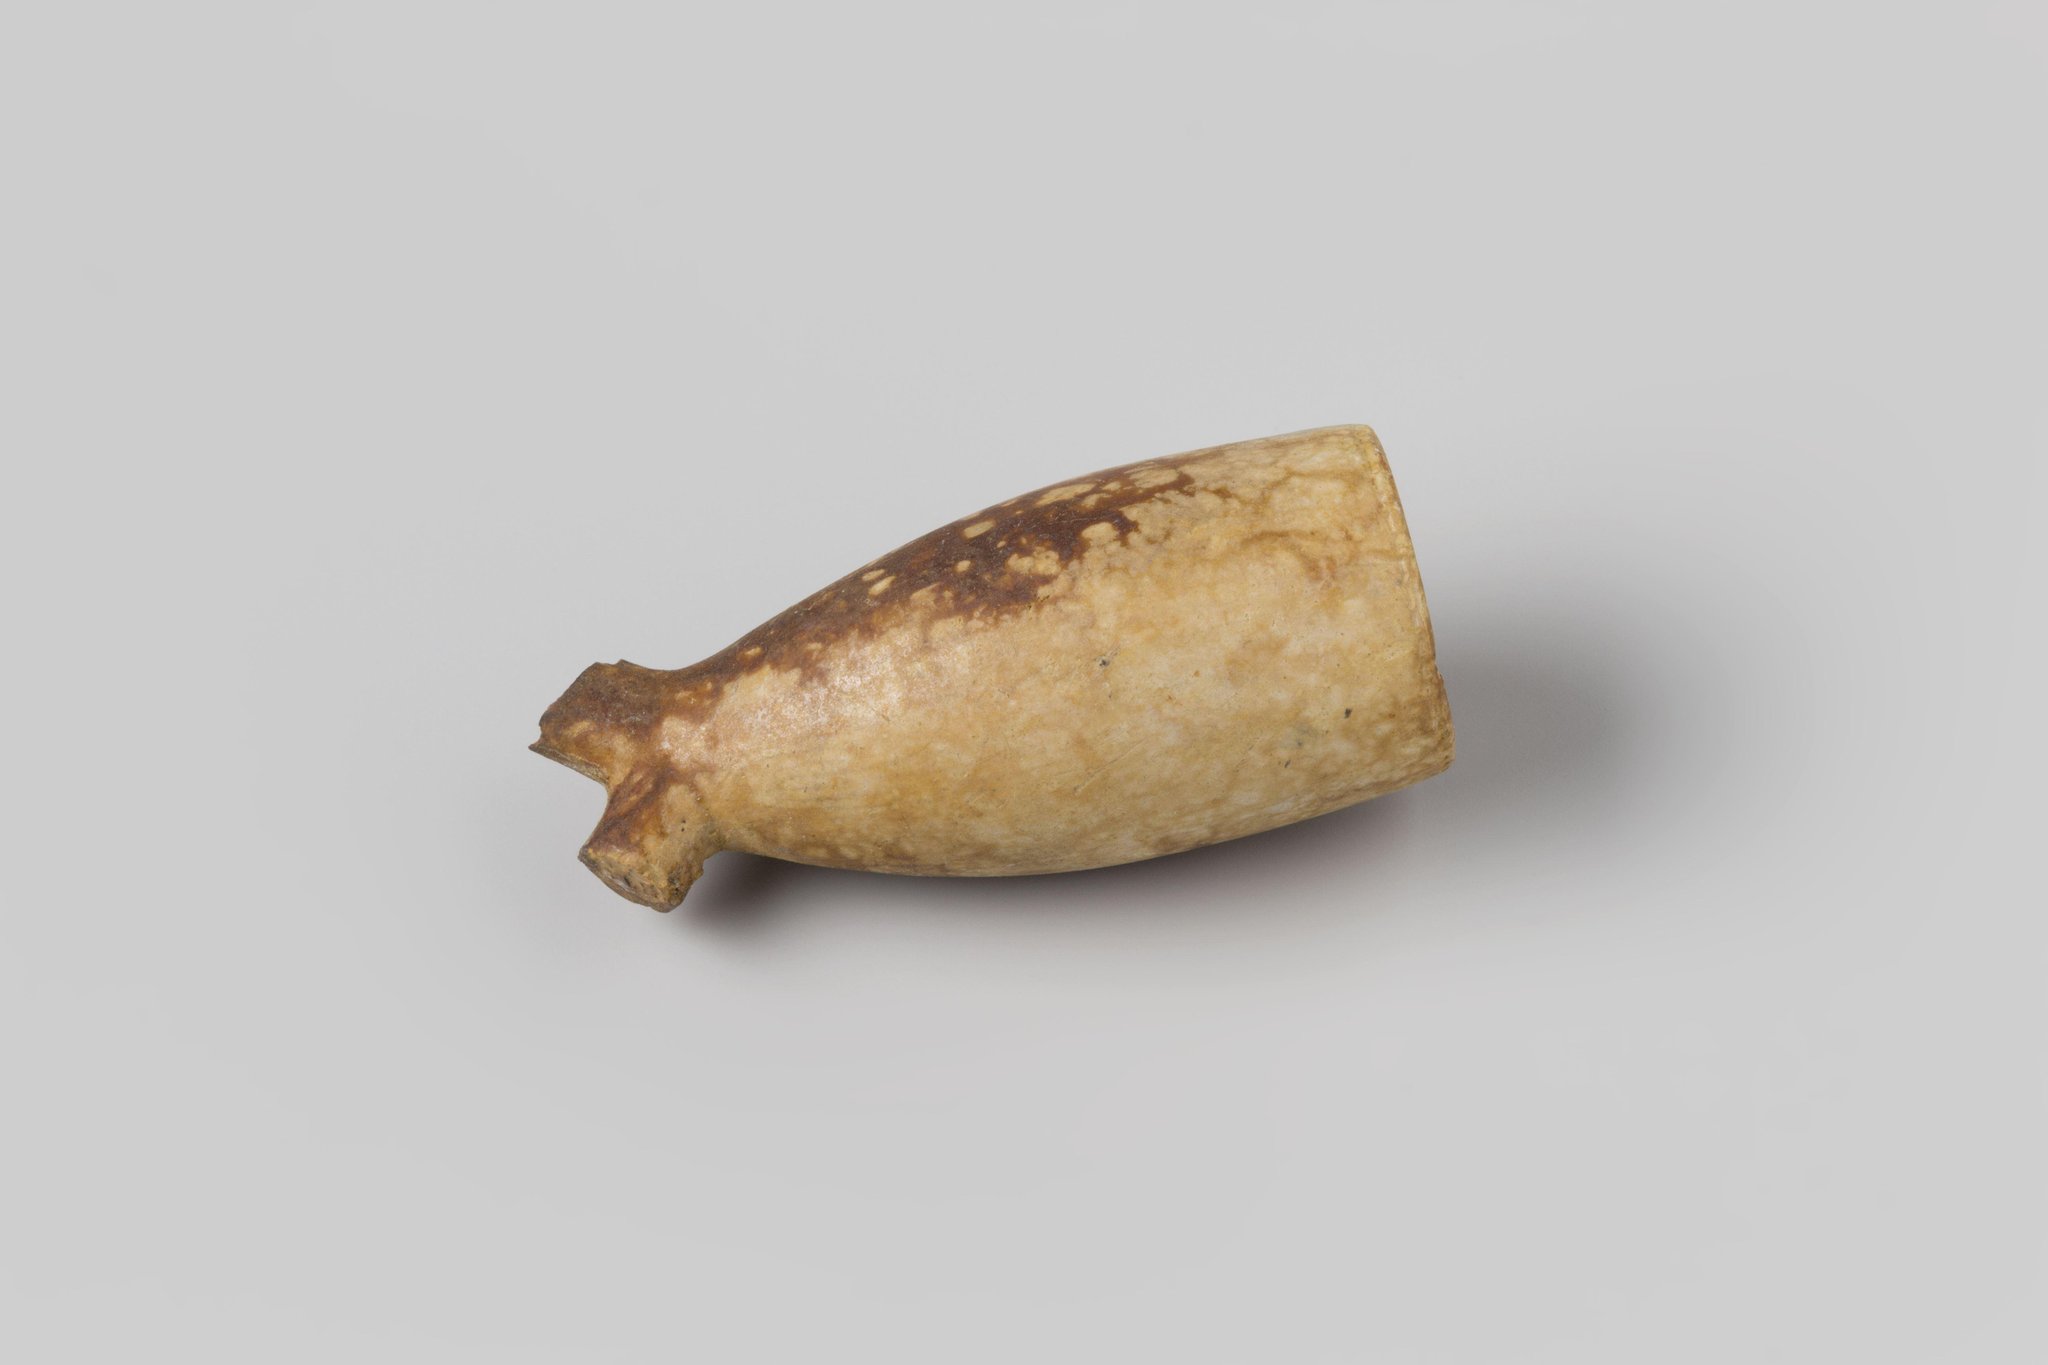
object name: pipe bowl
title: Pijpenkop uit het wrak van de Oost-Indiëvaarder Hollandia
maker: Anonymous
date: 1700-1743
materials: clay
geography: netherlands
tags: verenigde oostindische compagnie, hollandia (schip), annet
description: Pipe, bowl, heelmark: tobacco's brazier; no hsm.